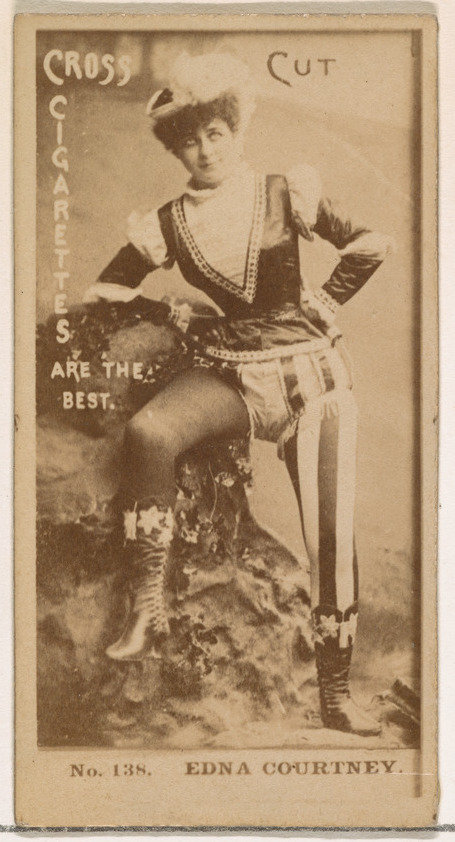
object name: print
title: Card Number 138, Edna Courtney, from the Actors and Actresses series (N145-2) issued by Duke Sons & Co. to promote Cross Cut Cigarettes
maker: w. duke, sons & co.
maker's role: publisher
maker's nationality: american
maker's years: 1870-1920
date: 1880-1889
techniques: albumen silver print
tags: portraits,women,actresses